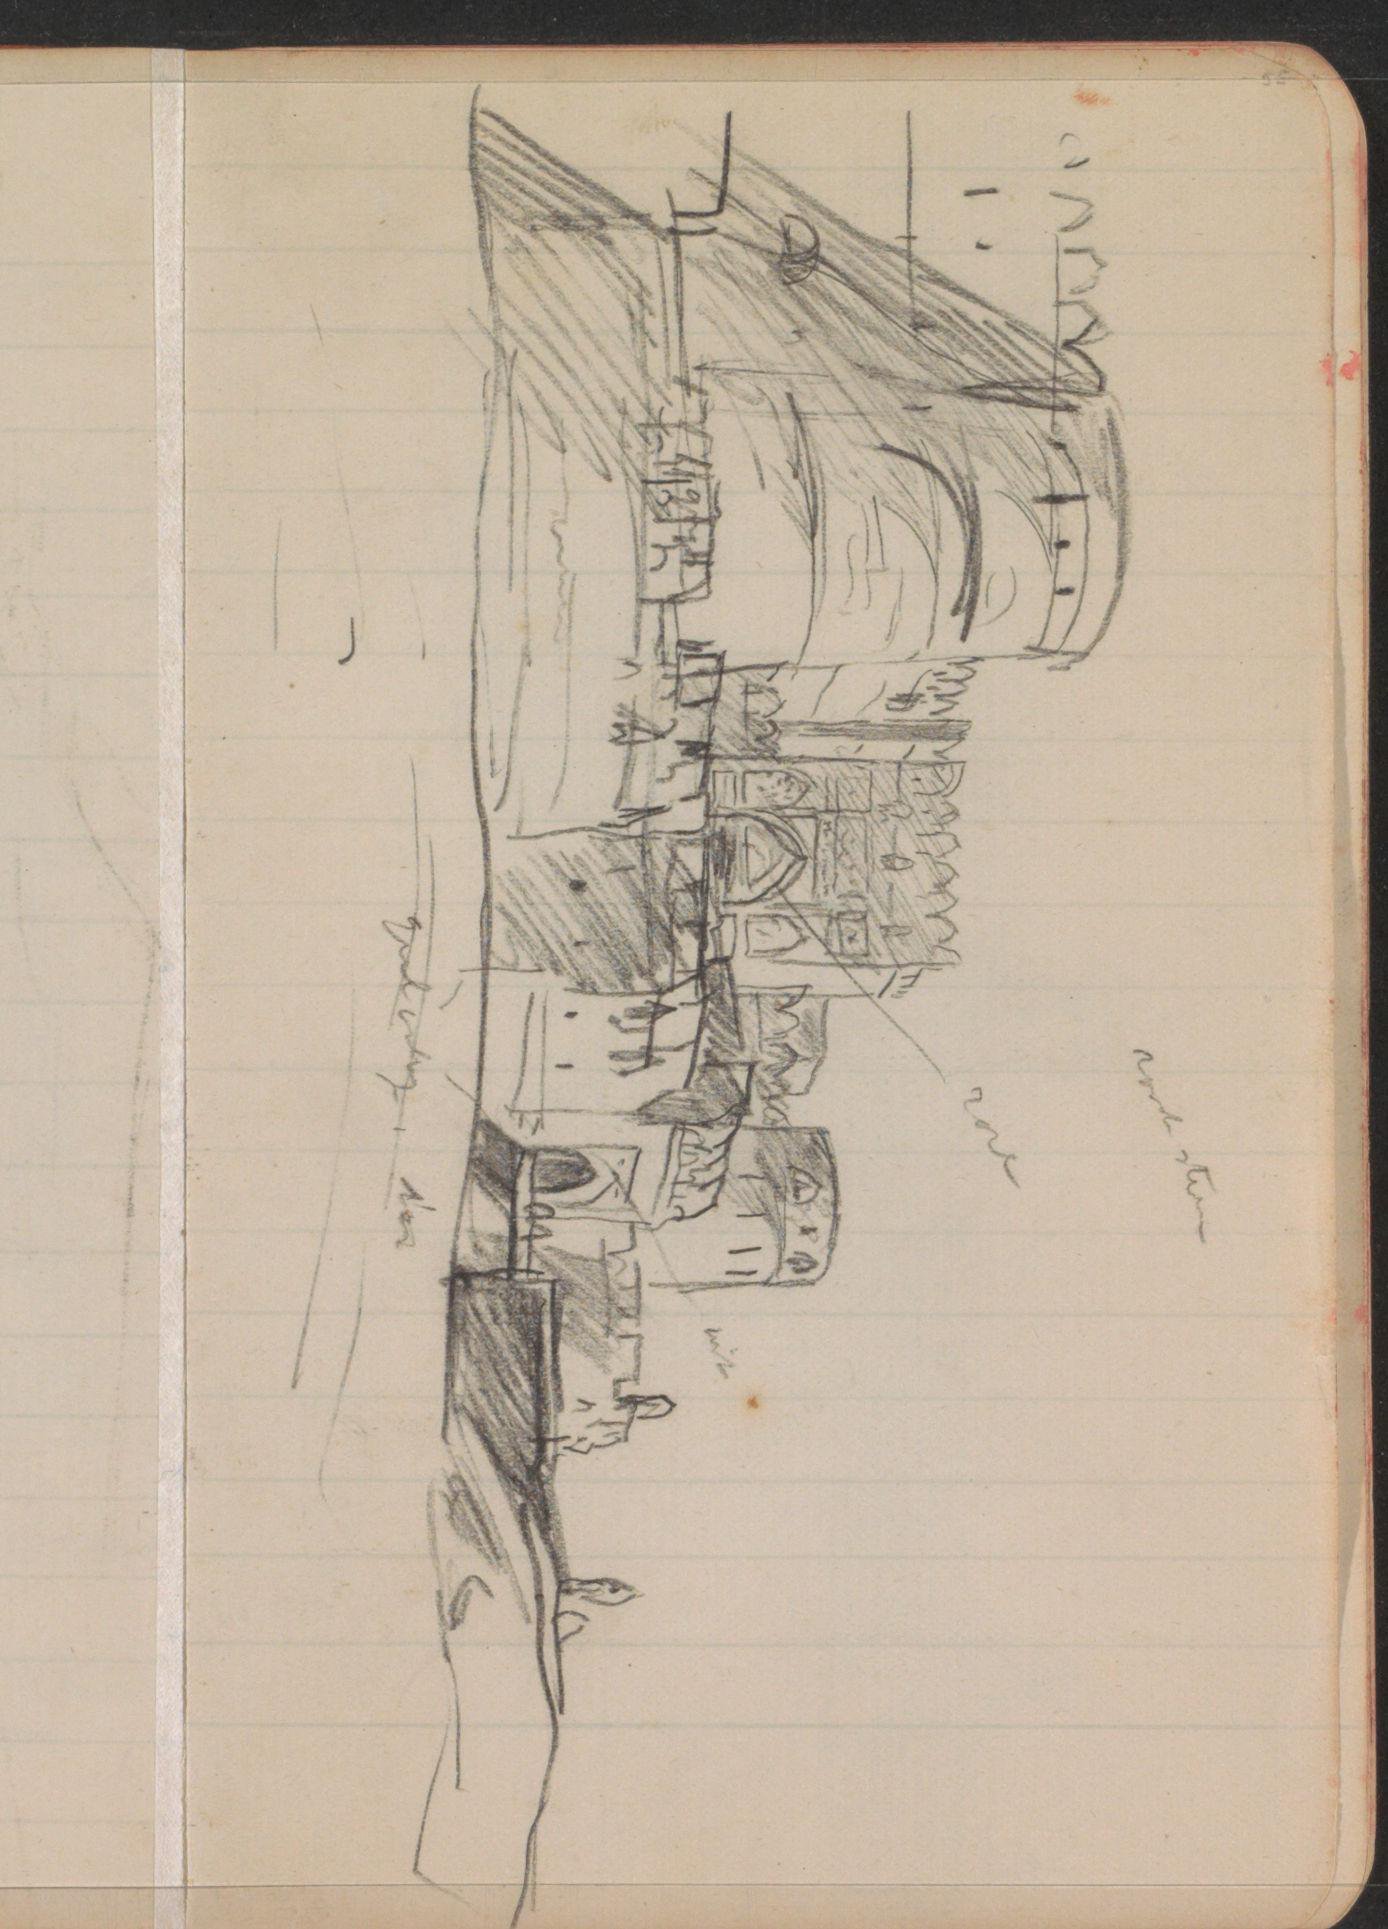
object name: sketchbook leaf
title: Fort van Agra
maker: marius bauer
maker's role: draughtsman, print maker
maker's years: 1867-1932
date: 1897-1898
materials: chalk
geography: agra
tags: gate ~ fortified city, towers ~ fortified city, walls ~ fortified city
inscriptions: kleurnotitie, handgeschreven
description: Vermoedelijk baseerde Bauer de ets 'Fort van Agra' op deze schets (zie documentatie).